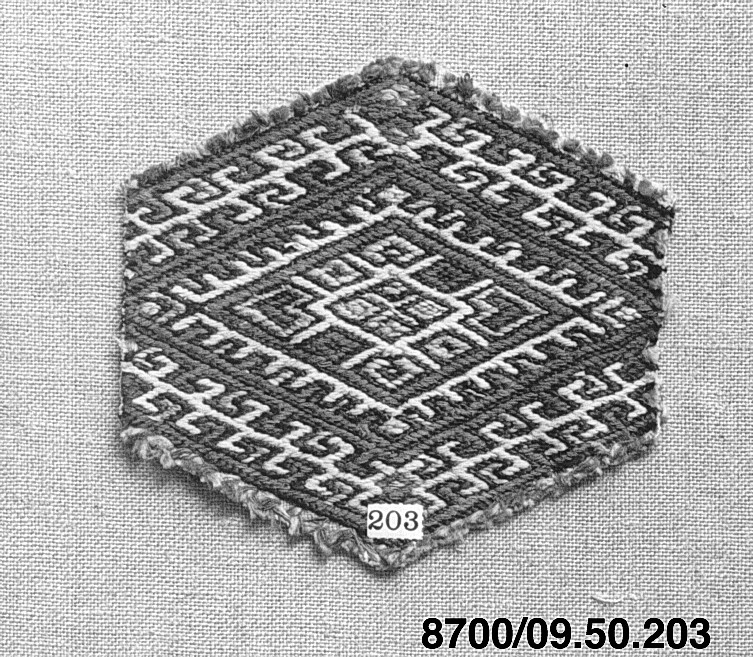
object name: costume fragment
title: Peasant costume fragment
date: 1701-1900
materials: canvas, silk